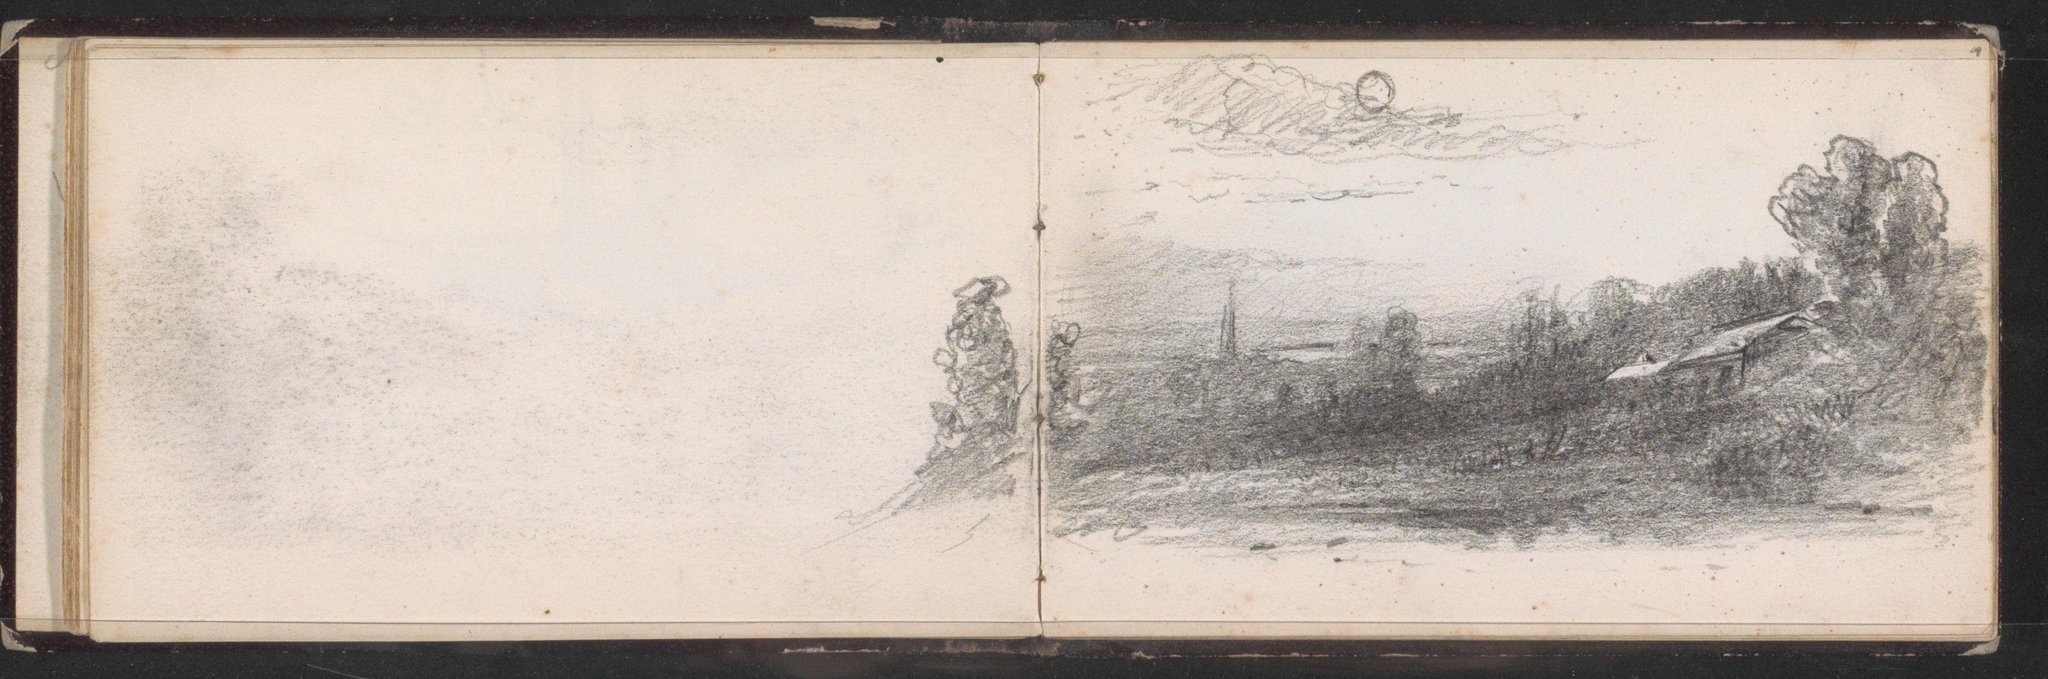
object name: sketchbook leaf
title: Landschap met een huis, kerktoren en bomen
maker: maria vos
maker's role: draughtsman, painter, print maker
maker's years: 1824-1906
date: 1863-1864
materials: paper, pencil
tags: city-view, and landscape with man-made constructions, rural housing, e.g. country-house, villa, cottage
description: Blad 18 verso en 19 recto uit een schetsboek met 41 bladen.